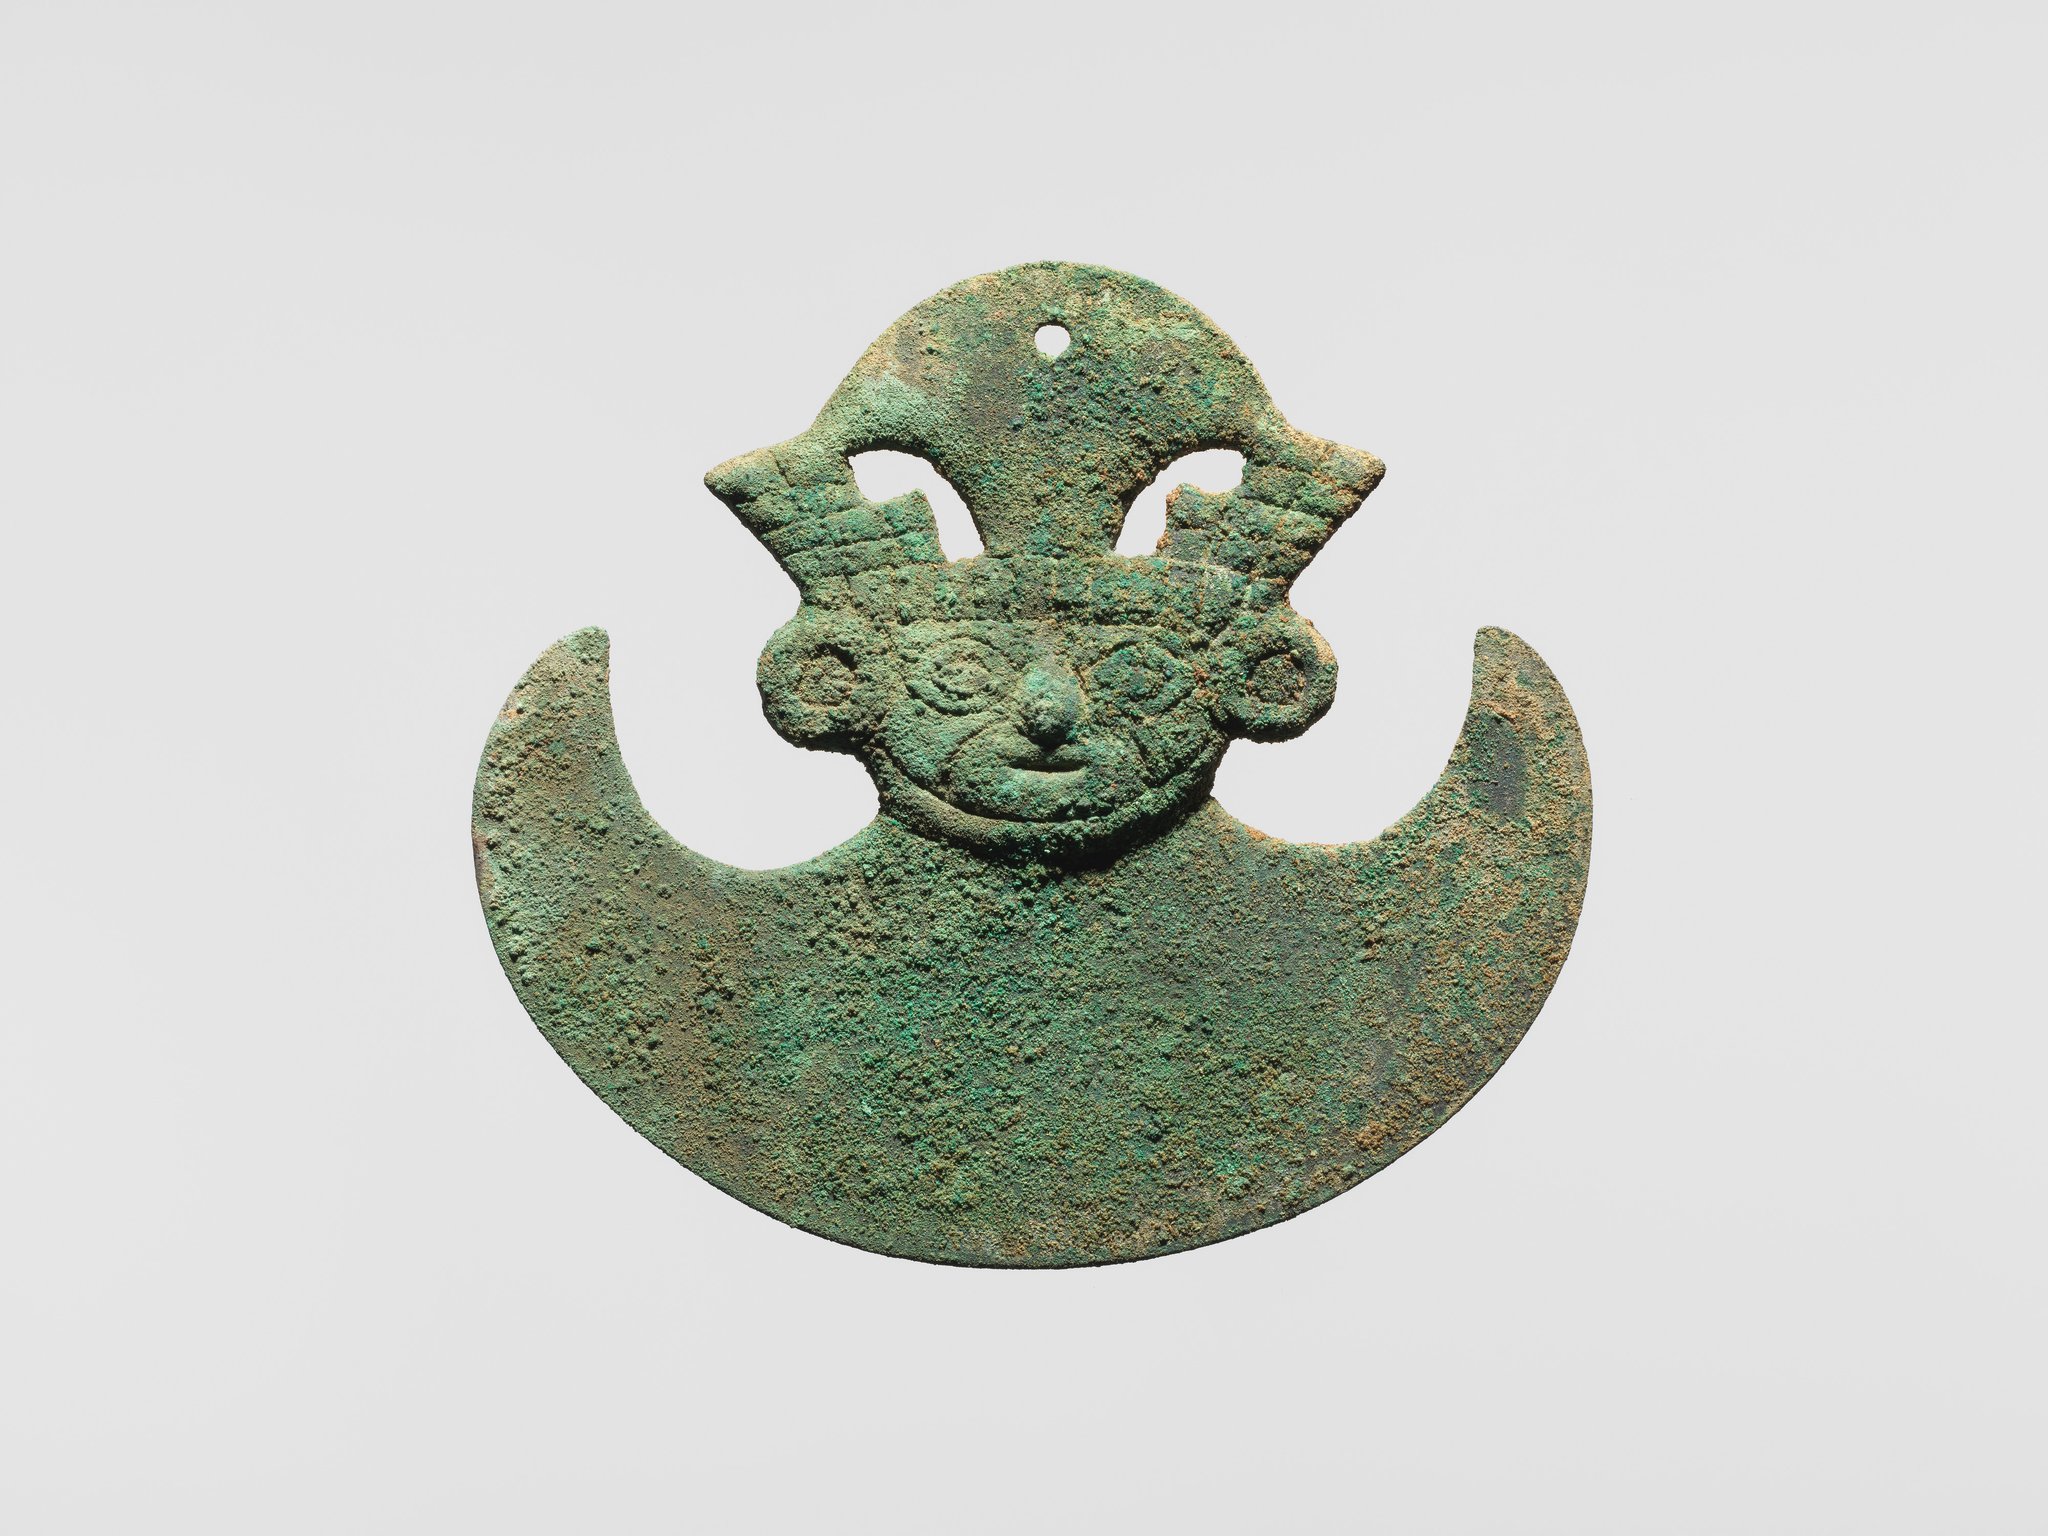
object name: ornament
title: Animal Ornament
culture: moche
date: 501-700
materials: copper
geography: peru